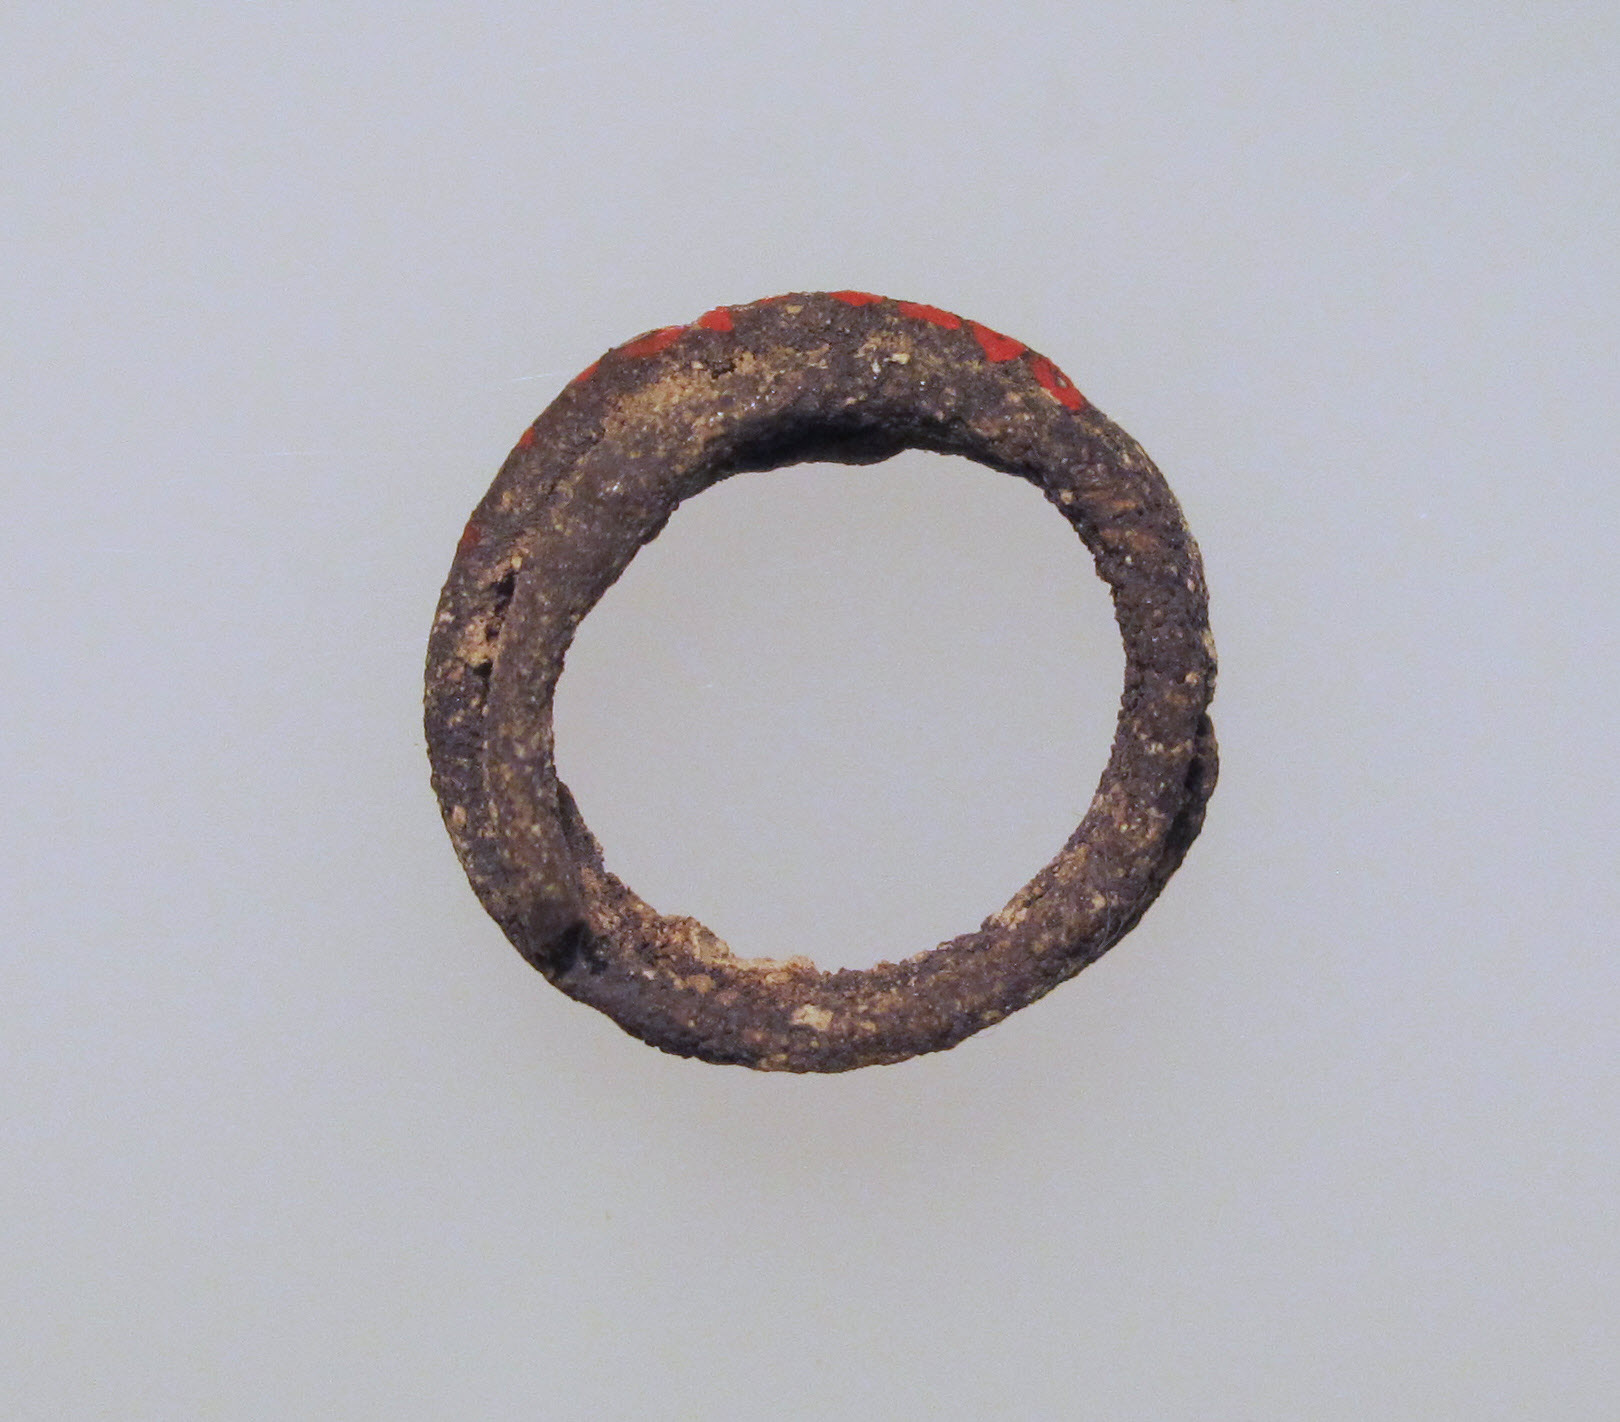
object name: earring or spiral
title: Silve earring or spiral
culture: cypriot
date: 3900 BCE-100 CE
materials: silver